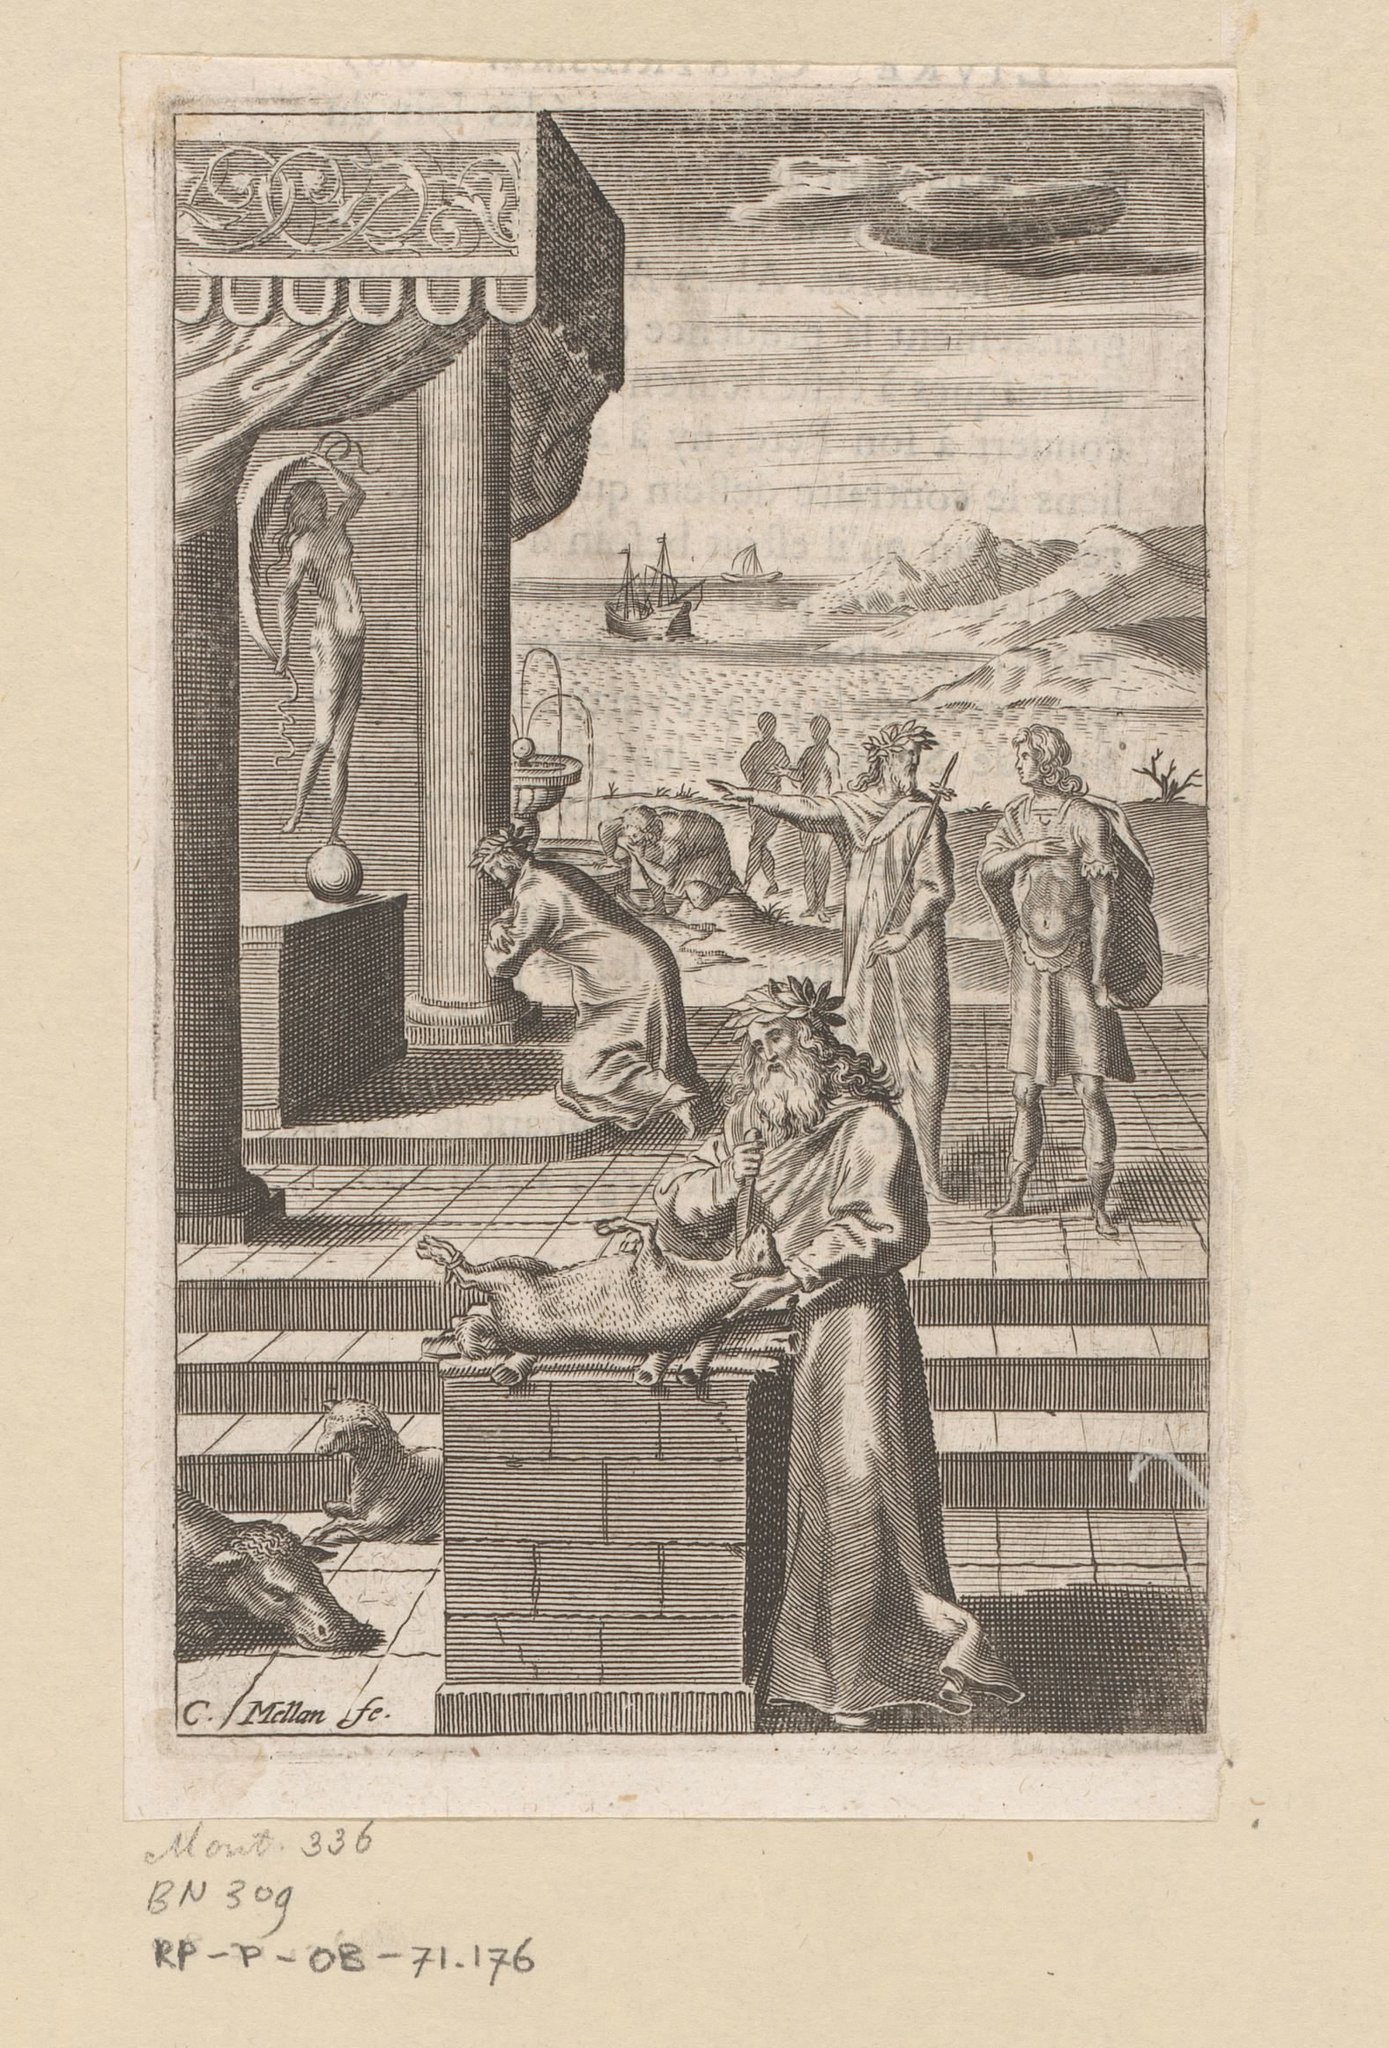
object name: book illustration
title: Arsidas aanbidt Fortuna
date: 1624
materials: paper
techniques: engraving, letterpress printing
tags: fables of lafontaine (fortuna en het kleine kind) : use 85(...), fortuna as roman personification, sacrifice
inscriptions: collector's mark: Lugt 240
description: Prent uit: Barclay, Jean. L'Argenis. Traduction nouvelle enrichie de figures. Parijs: Nicolas Buon, 1624, dl. 4, hoofdstuk 7. In 1625 werd een tweede editie uitgegeven, eveneens door Nicolas Buon en in 1636 werd een Engelse vertaling uitgegeven door Henry Seile in Londen.